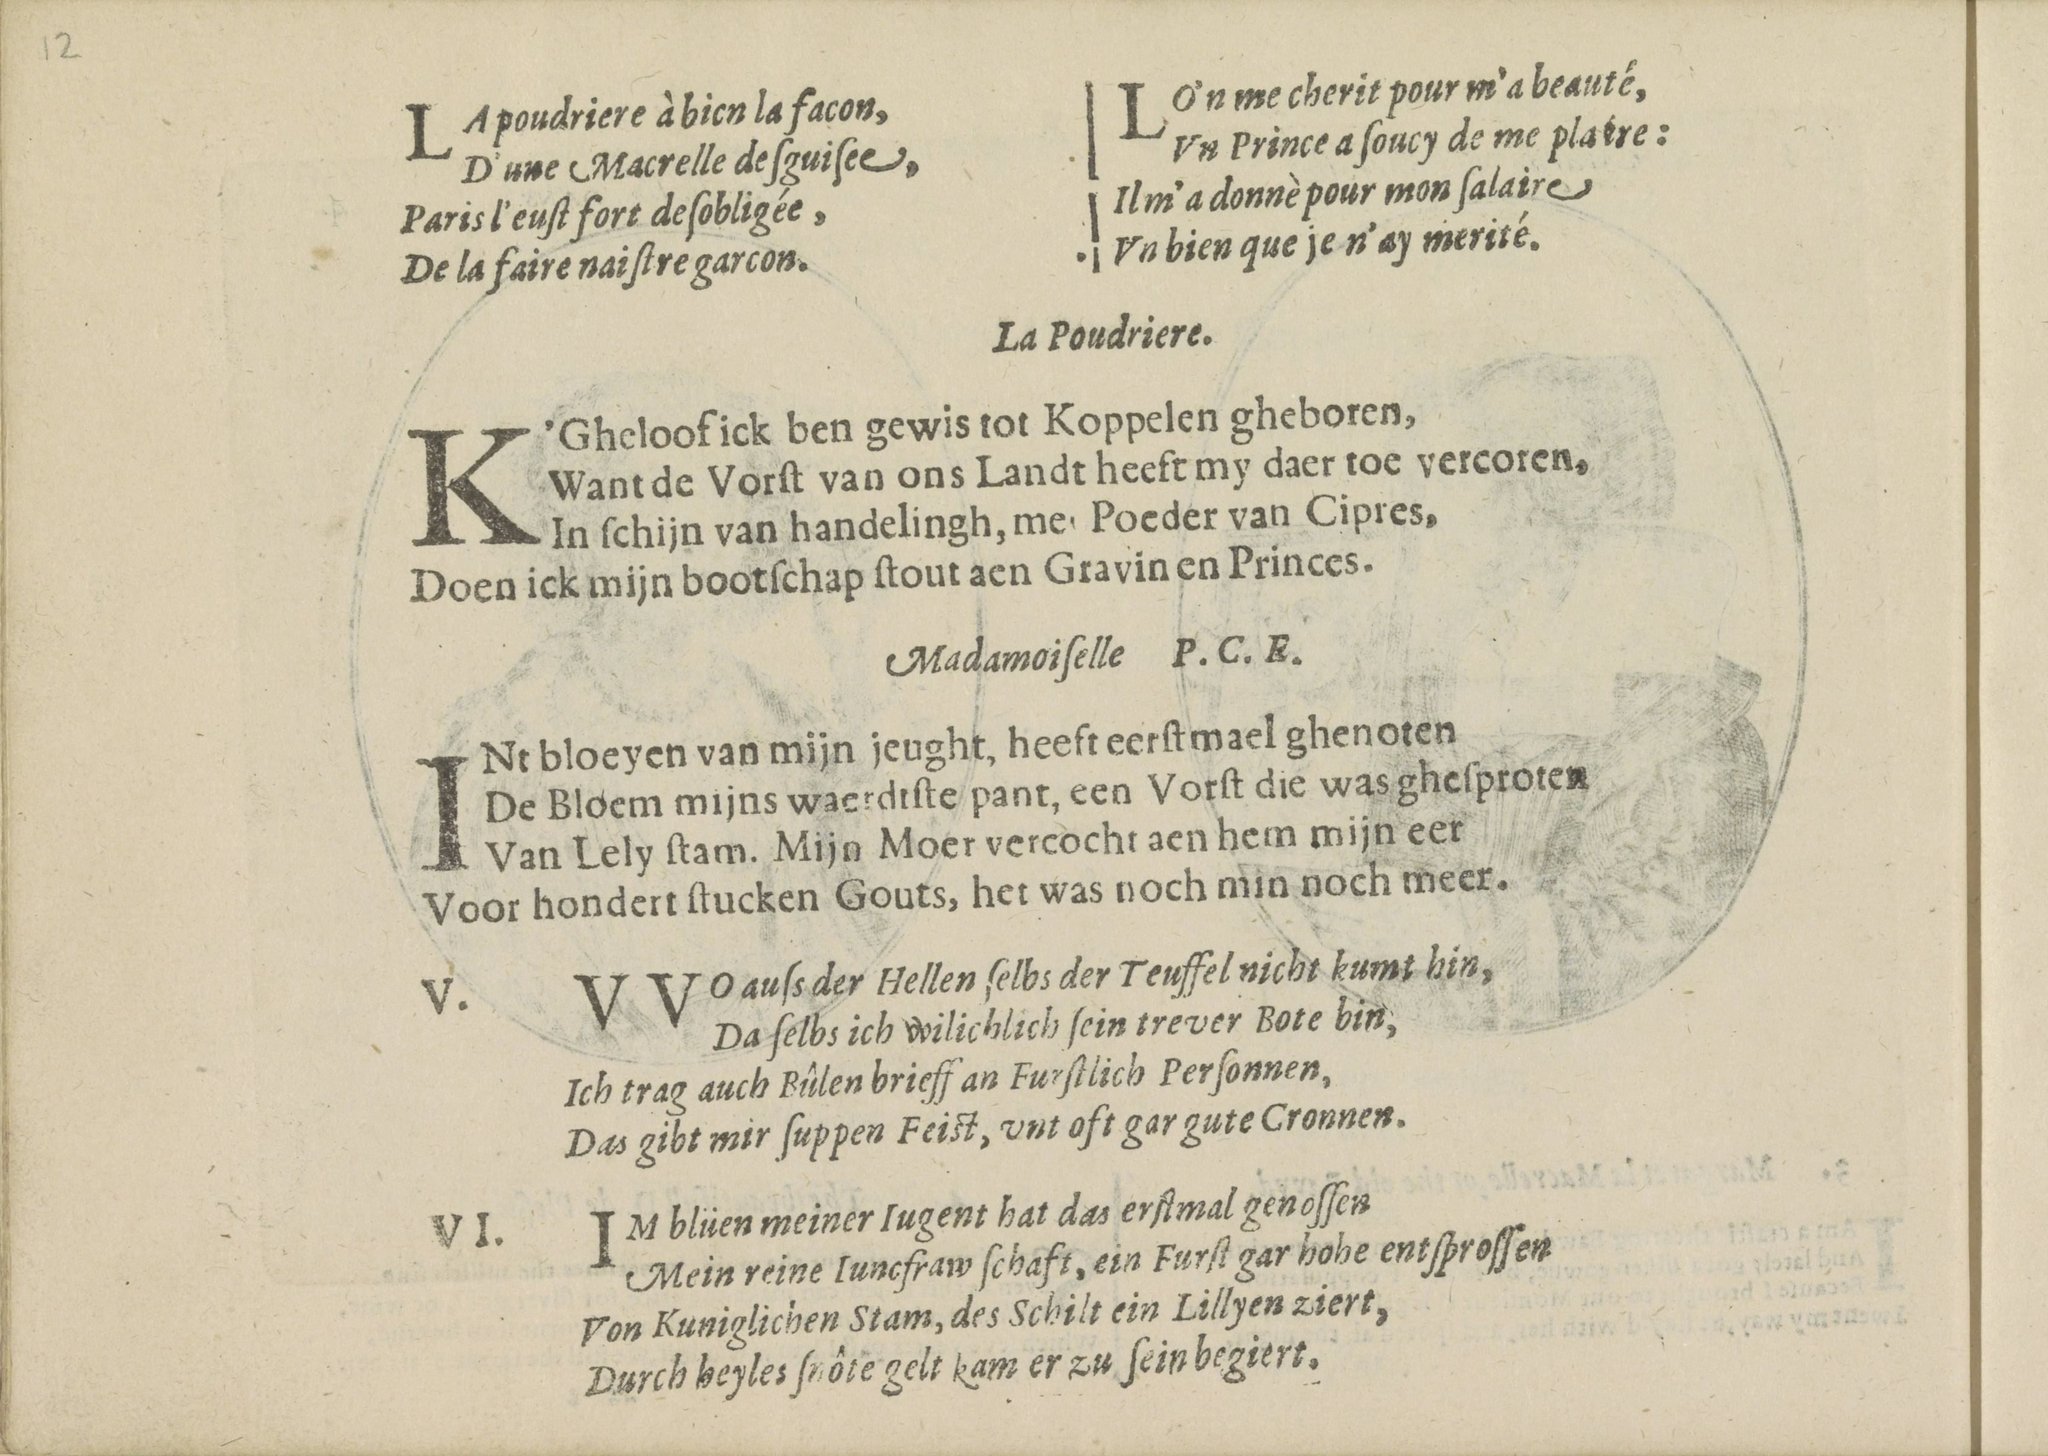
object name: album leaf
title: Kwatrijnen bij de portretten van de koppelaarster genaamd La Poudriere Macrelle en de courtisane Madamoiselle F.C.E. de Court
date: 1635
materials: paper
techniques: letterpress printing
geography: utrecht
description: Drie keer twee kwatrijnen in het Frans, Nederlands en Duits bij de portretten van de koppelaarster La Poudriere (Macrelle) en de courtisane Madamoiselle F.C.E. de Court (op dit tekstblad P.C.E). Het blad maakt deel uit van een album.